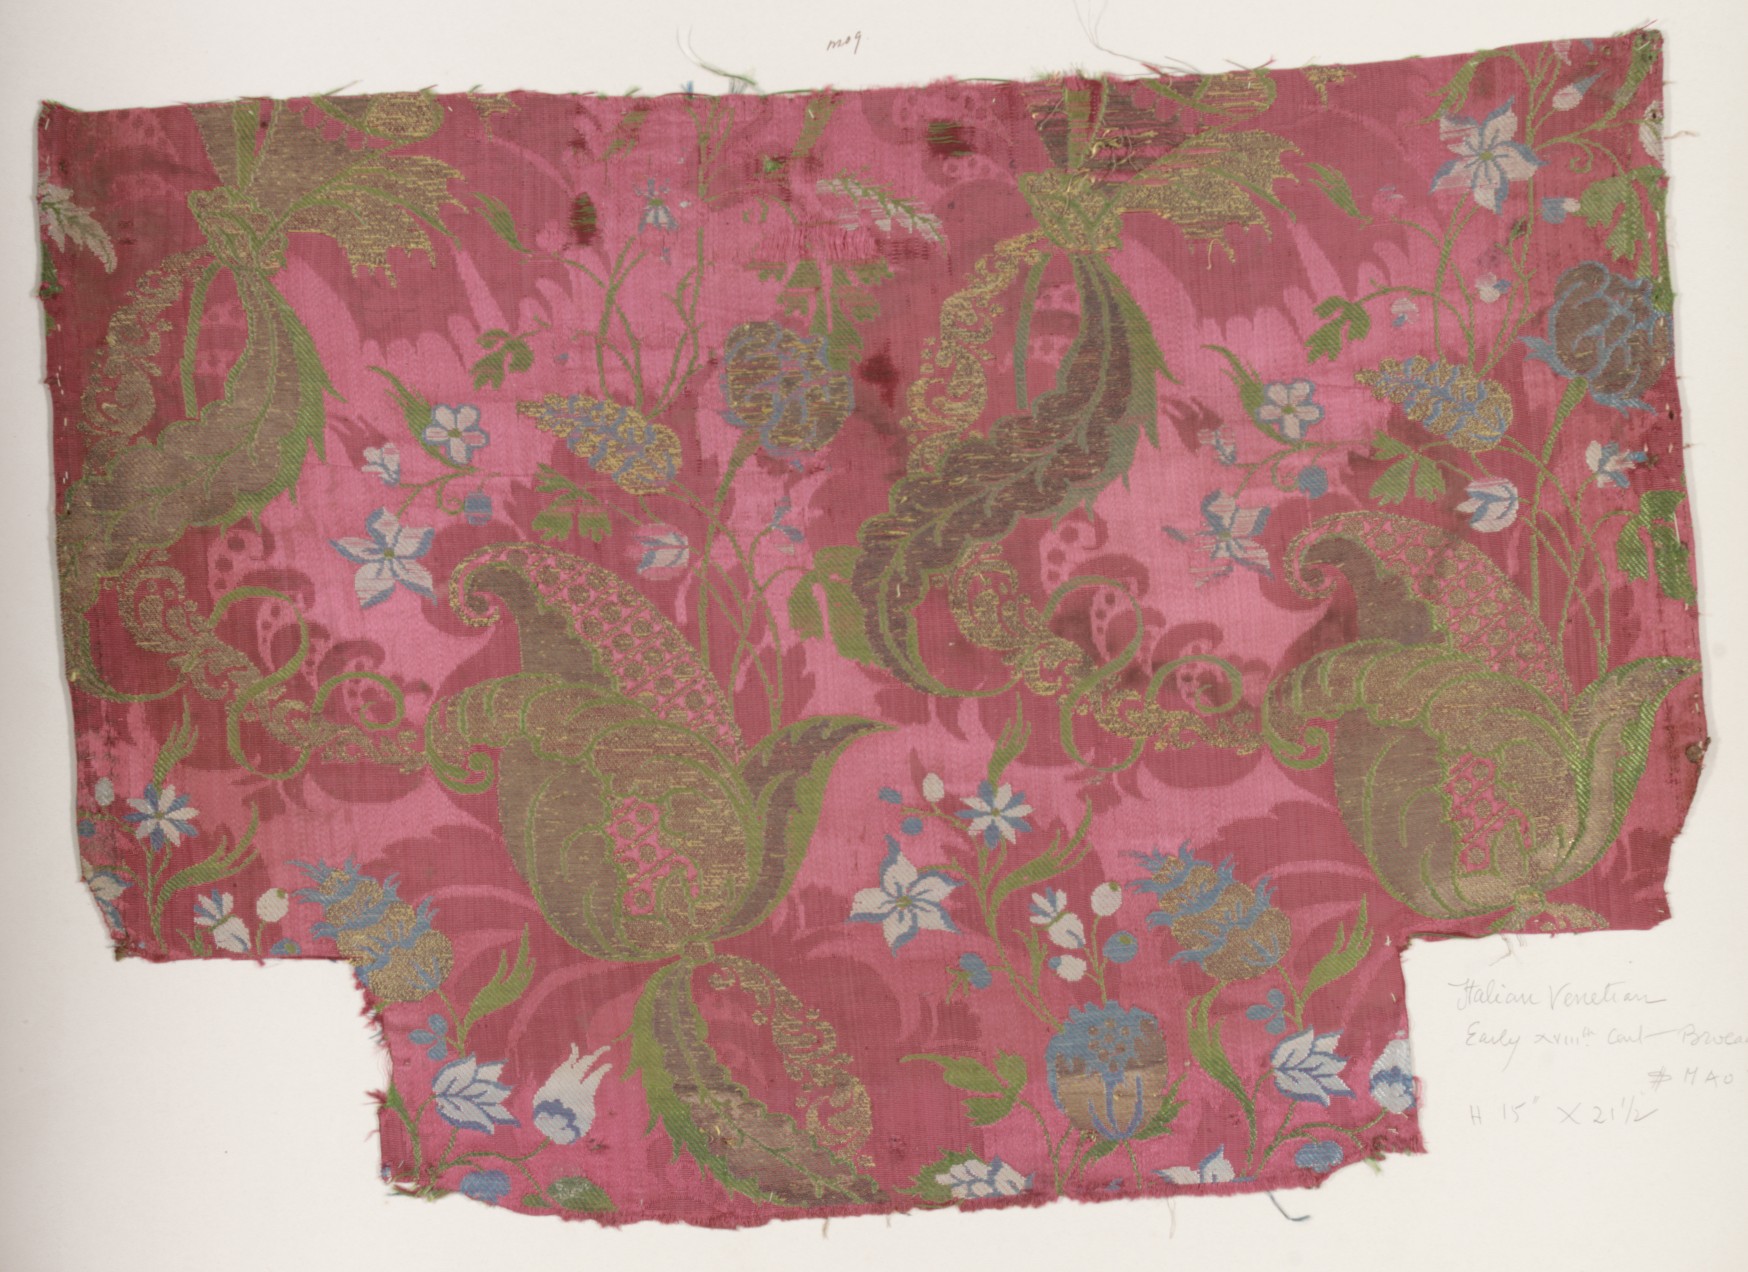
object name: fragment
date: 1701-1733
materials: metal thread, silk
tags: flowers,leaves